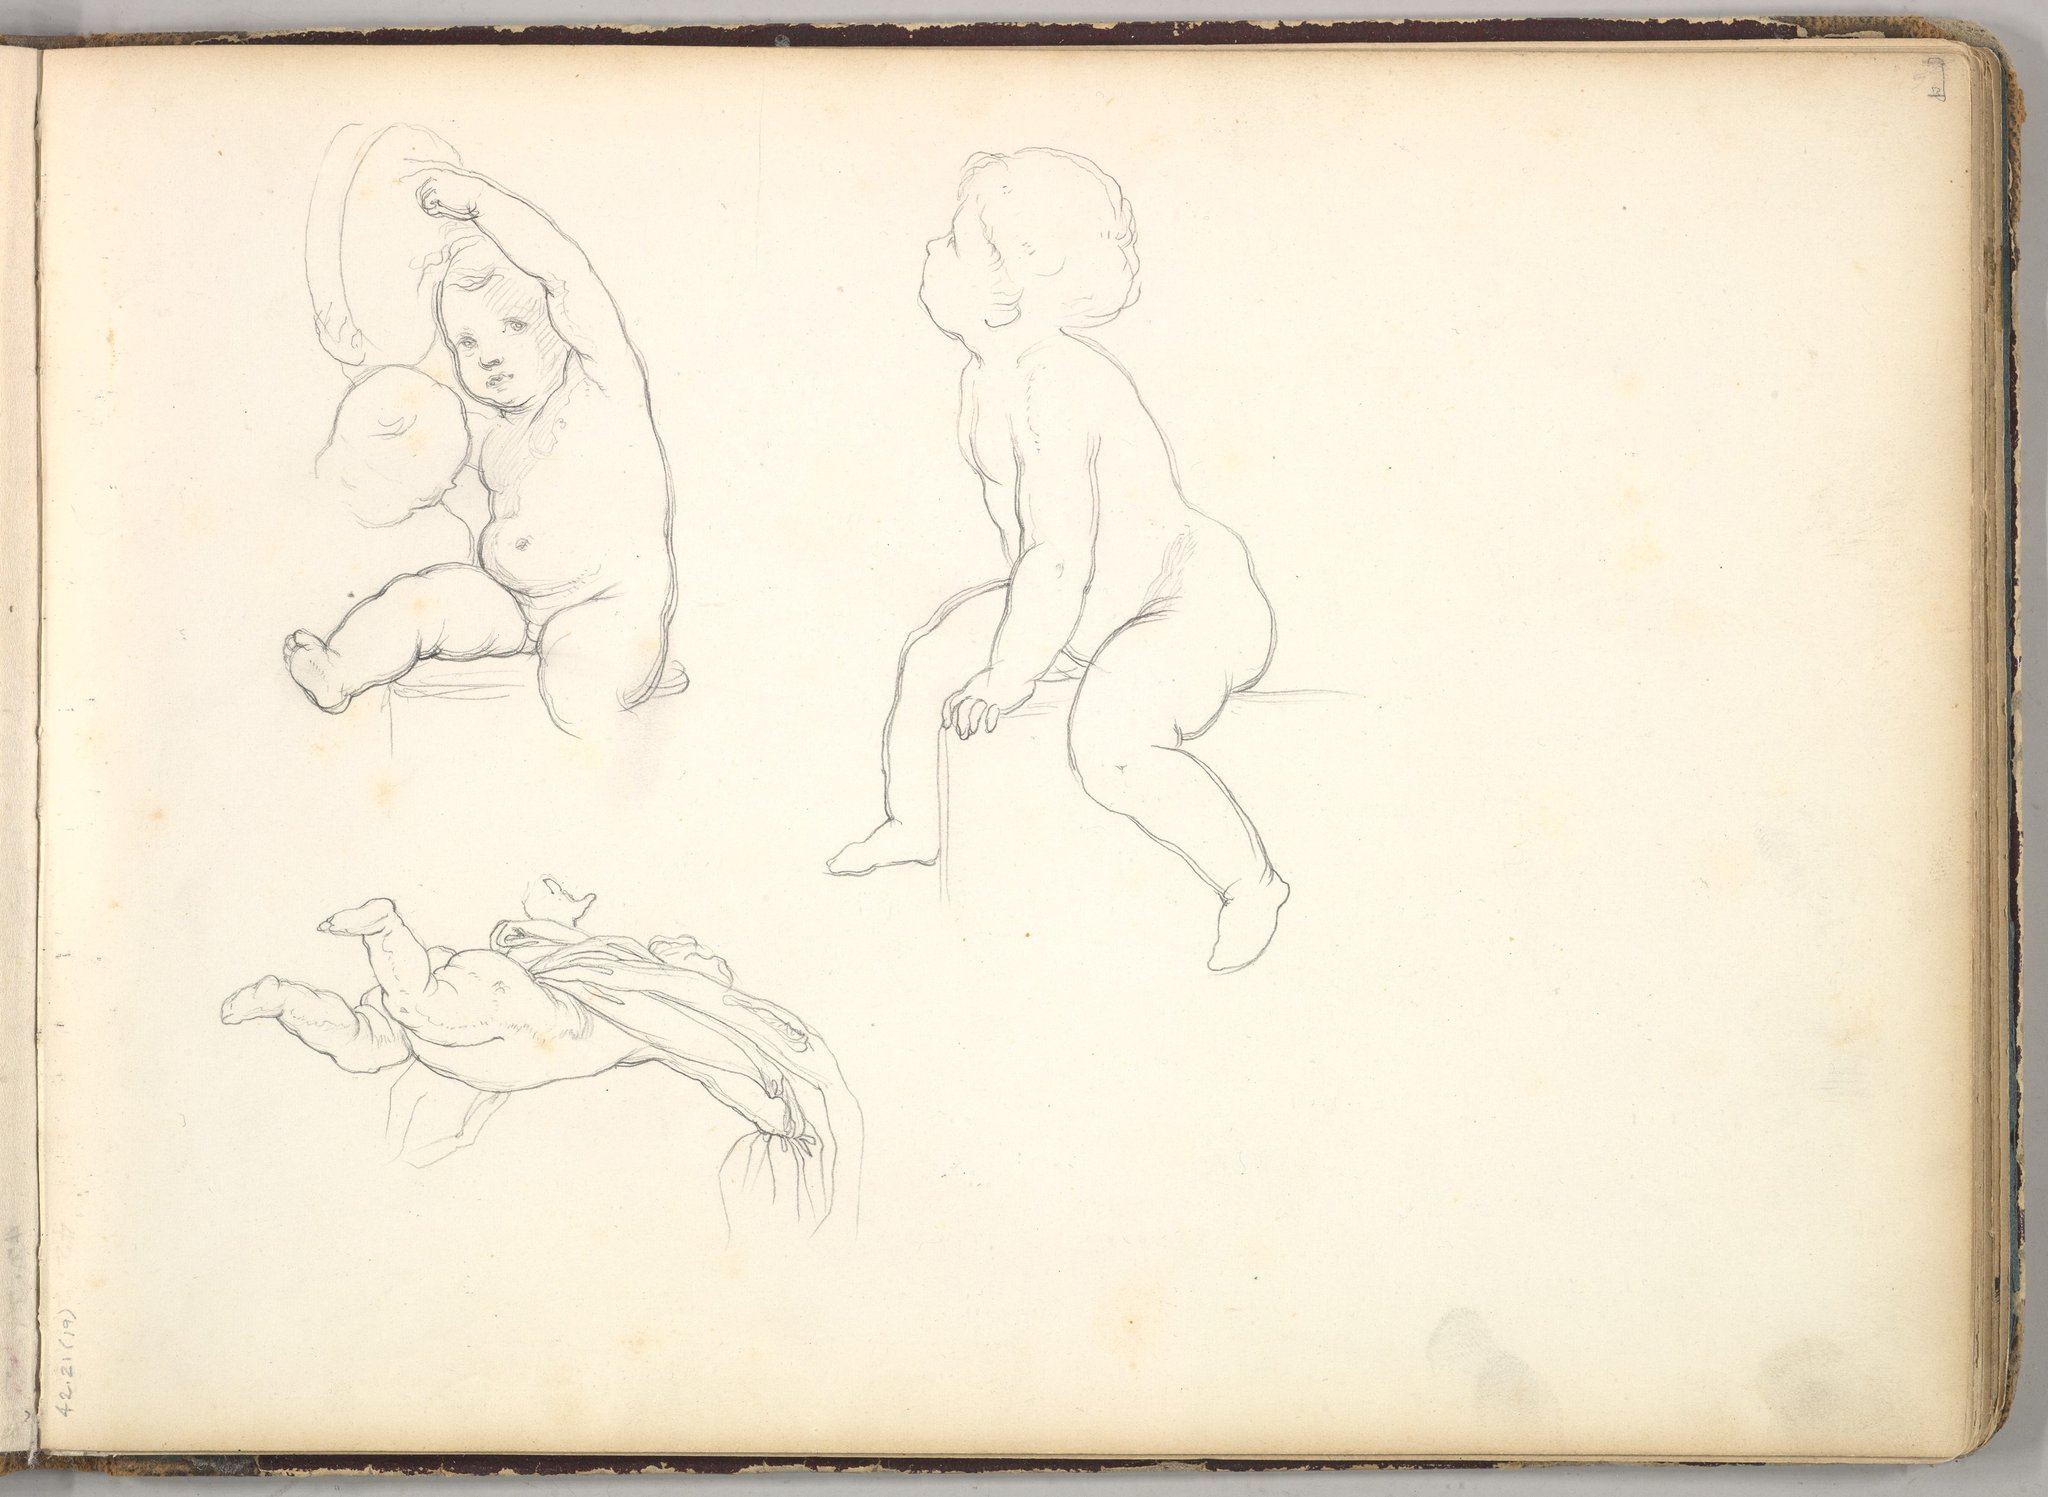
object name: drawing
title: Three Children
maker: frederic, lord leighton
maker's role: artist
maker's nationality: british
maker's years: 1830-1896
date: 1849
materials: graphite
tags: children